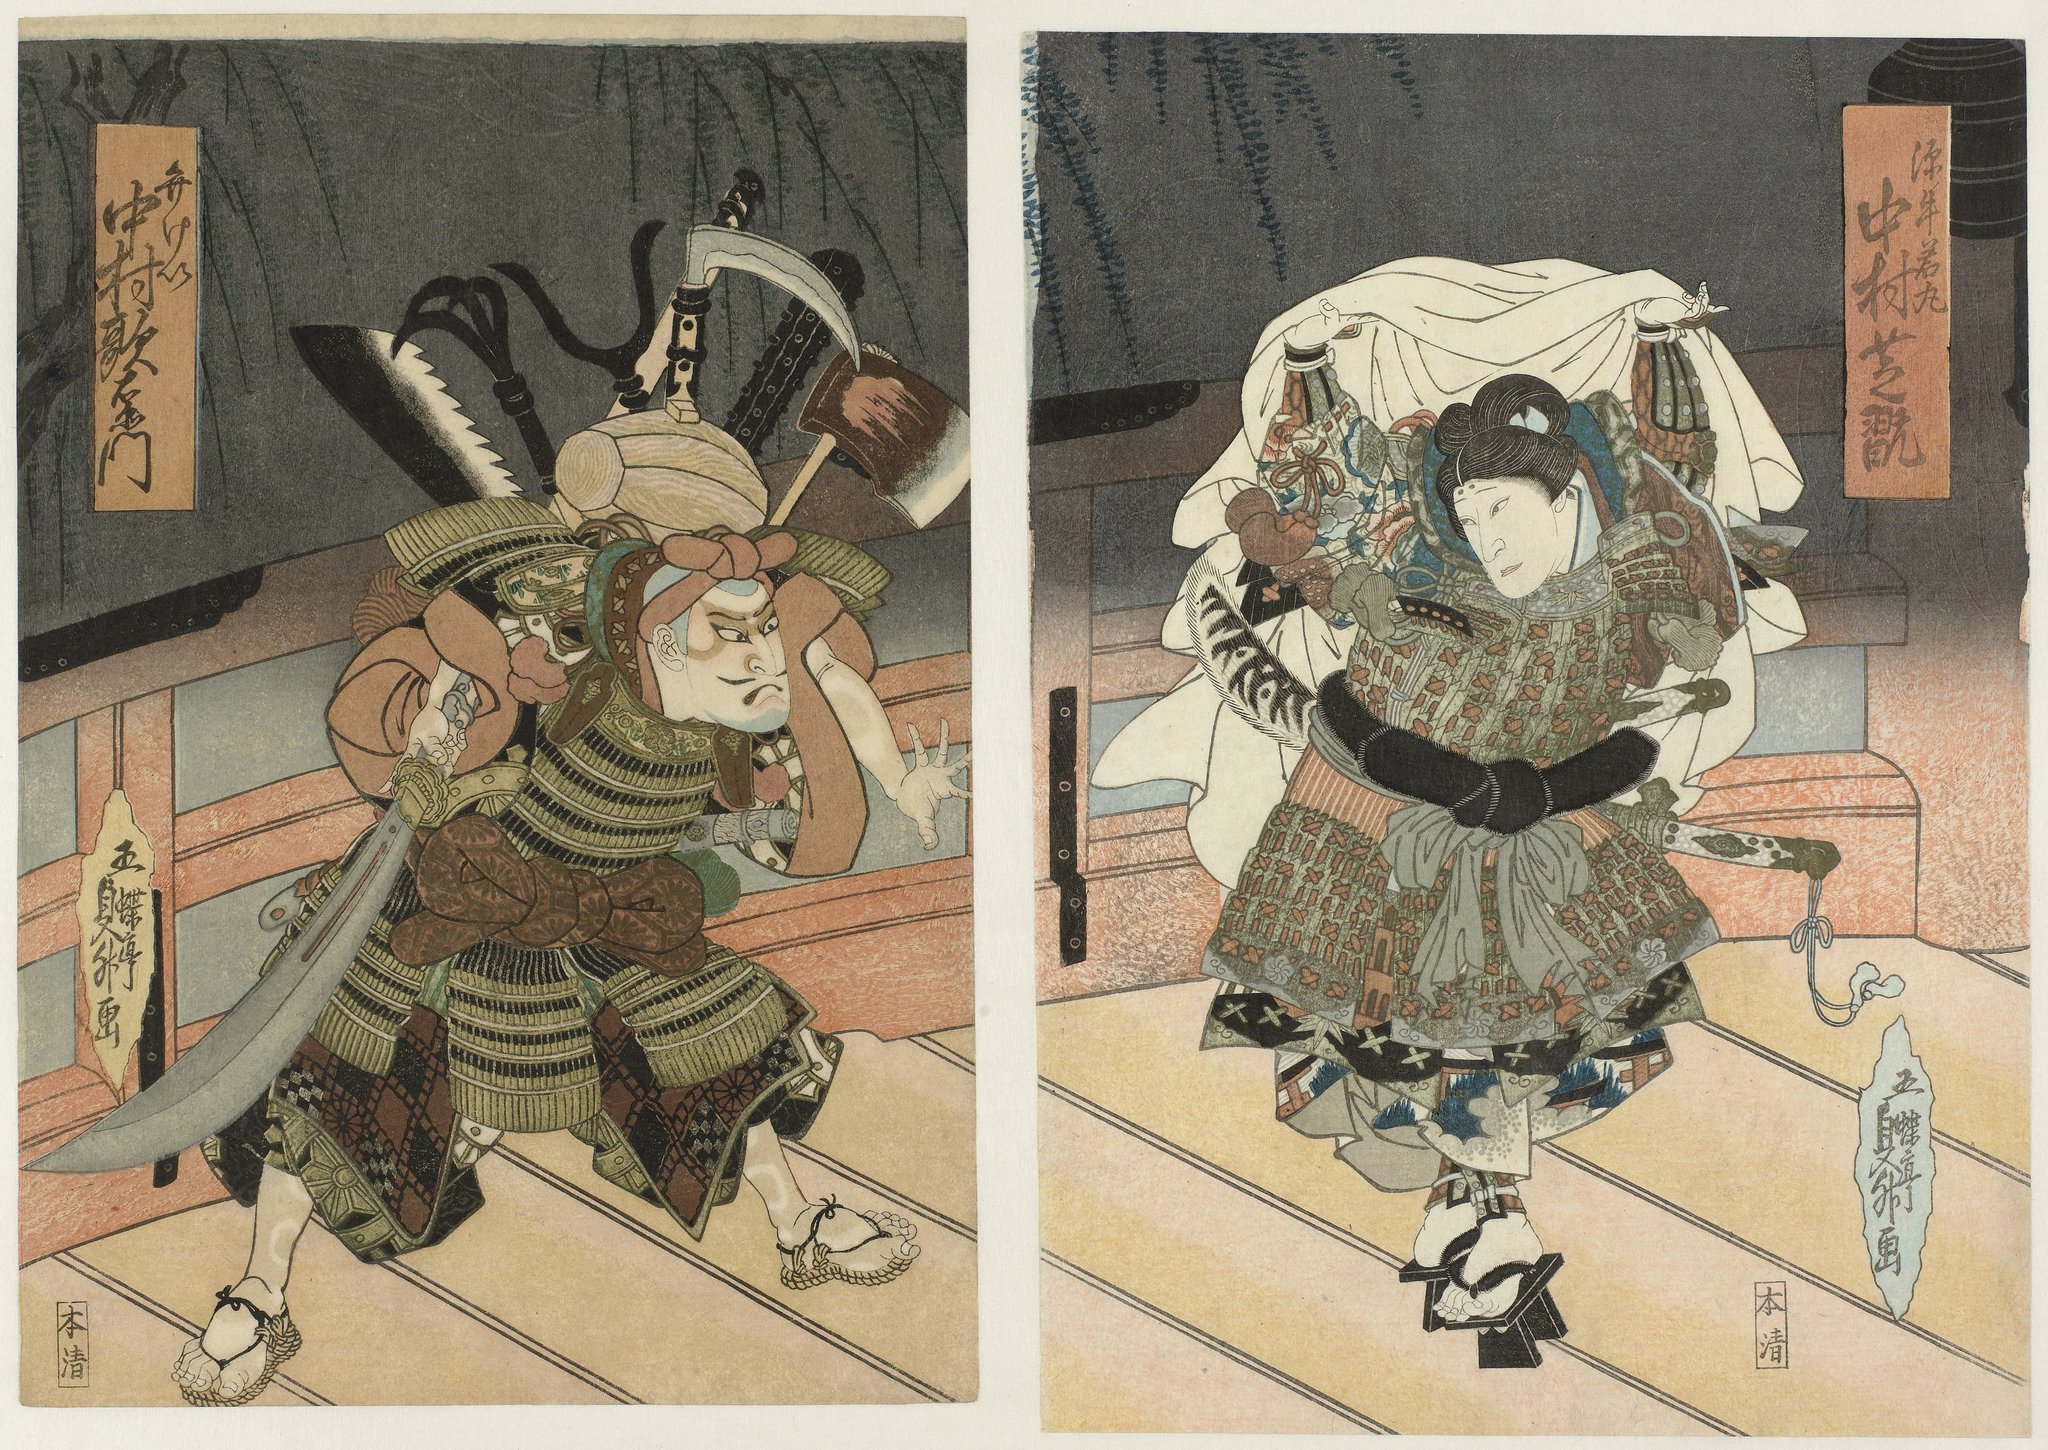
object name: print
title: Twee mannen op een brug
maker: gochôtei sadamasu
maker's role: print maker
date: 1837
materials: paper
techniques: woodcut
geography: osaka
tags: group of actors, troupe; actors on the stage, weapons, bridge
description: Twee acteurs op een brug. Nakamura Utaemon IV in de rol van Benkei, met verschillende wapens op zijn rug en een groot zwaard in de hand, en Nakamura Shikan III in de rol van Ushiwakamaru met een wit doek boven zijn hoofd. Scene uit het stuk "Kiichi hôgen sanryaku no maki", opgevoerd in het Naka Theater, in de negende maand van 1837. Diptiek.